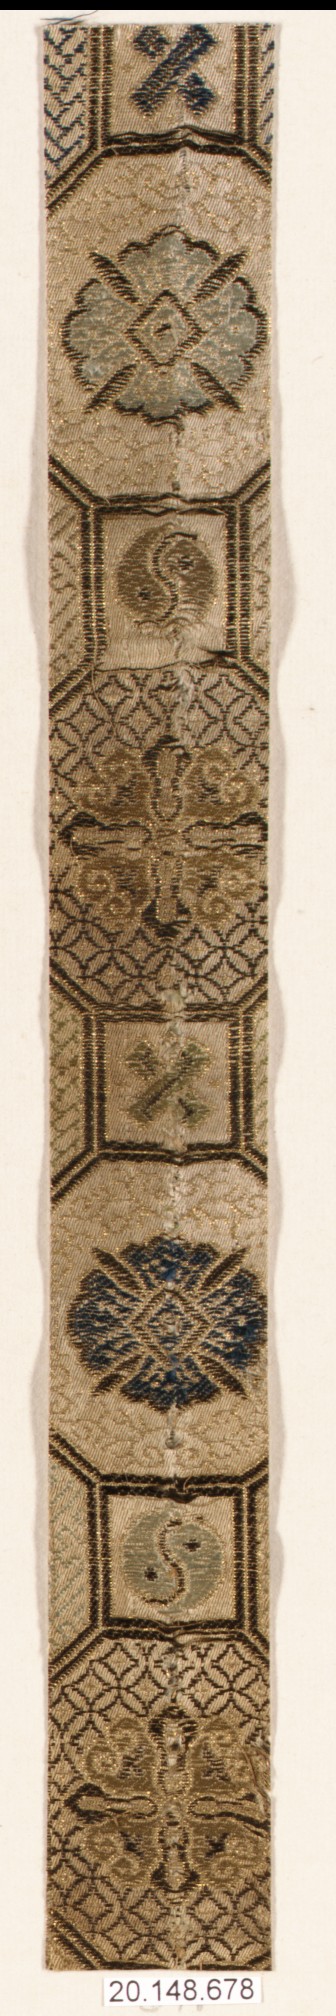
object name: piece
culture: japanese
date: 1701-1800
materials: silk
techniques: compound weave